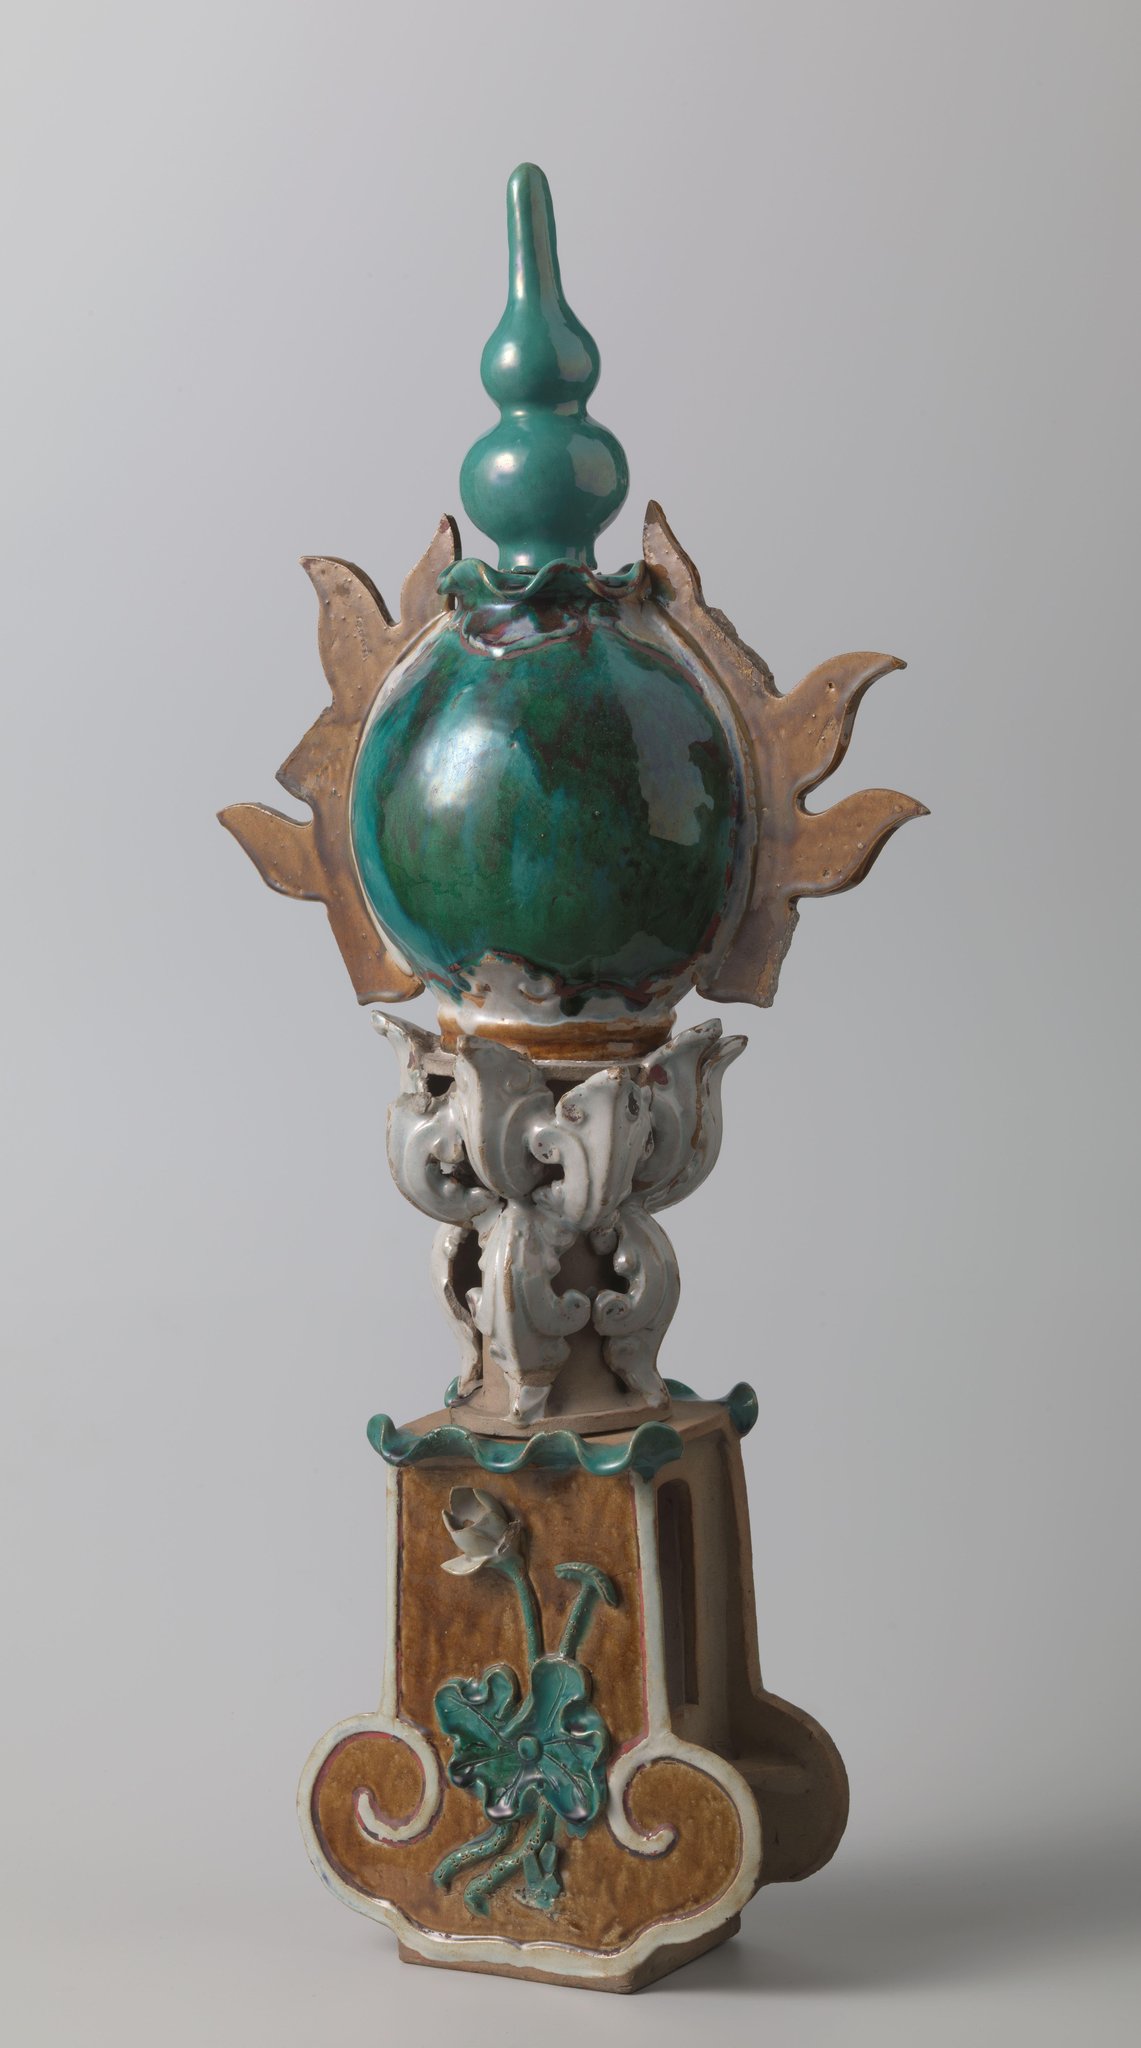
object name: sculpture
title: Ornament, onderdeel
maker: Anonymous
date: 1800-1850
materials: glaze, stoneware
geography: guangdong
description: Onderste deel van ornament. Steengoed met verschillende kleuren glazuur.